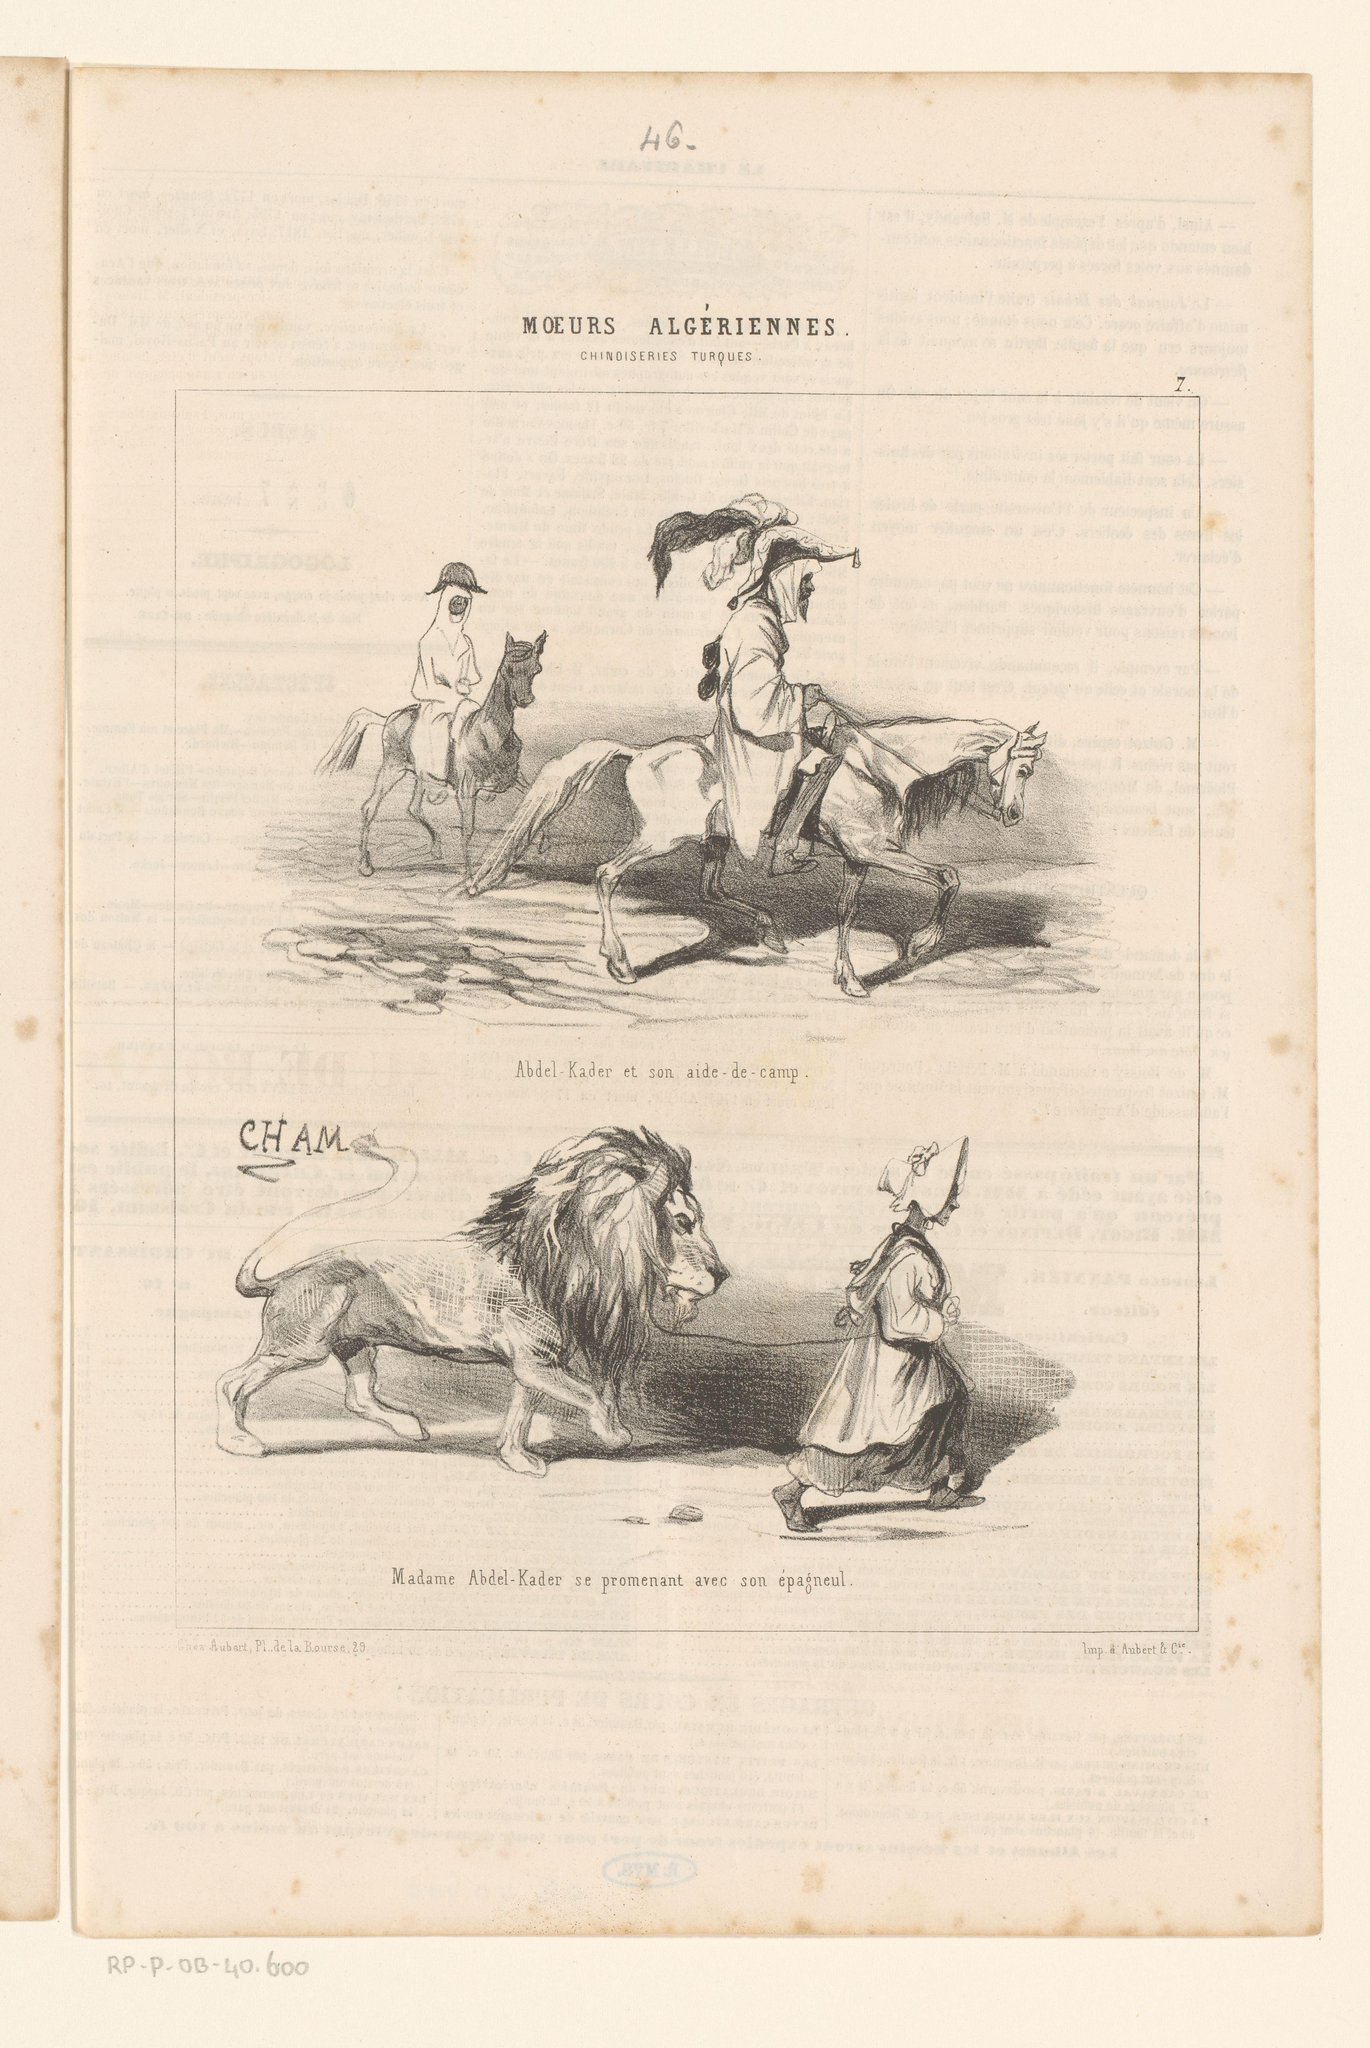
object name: print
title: Madame Abdel-Kader se promenant avec son épagneul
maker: cham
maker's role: print maker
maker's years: 1818-1879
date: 1844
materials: paper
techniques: letterpress printing, lithograph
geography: paris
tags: riding a horse, ass, or mule; rider, horseman, beasts of prey, predatory animals: lion, friendship between man and animal; caressing, petting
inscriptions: collector's mark: Lugt 2228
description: Prent uit: Le Charivari 13 (1844), nr. 33, 2 februari 184. De serie ‘Moeurs algériennes. Chinoiseries Turques’ is ook los van deze krant uitgegeven bij Aubert & Cie.